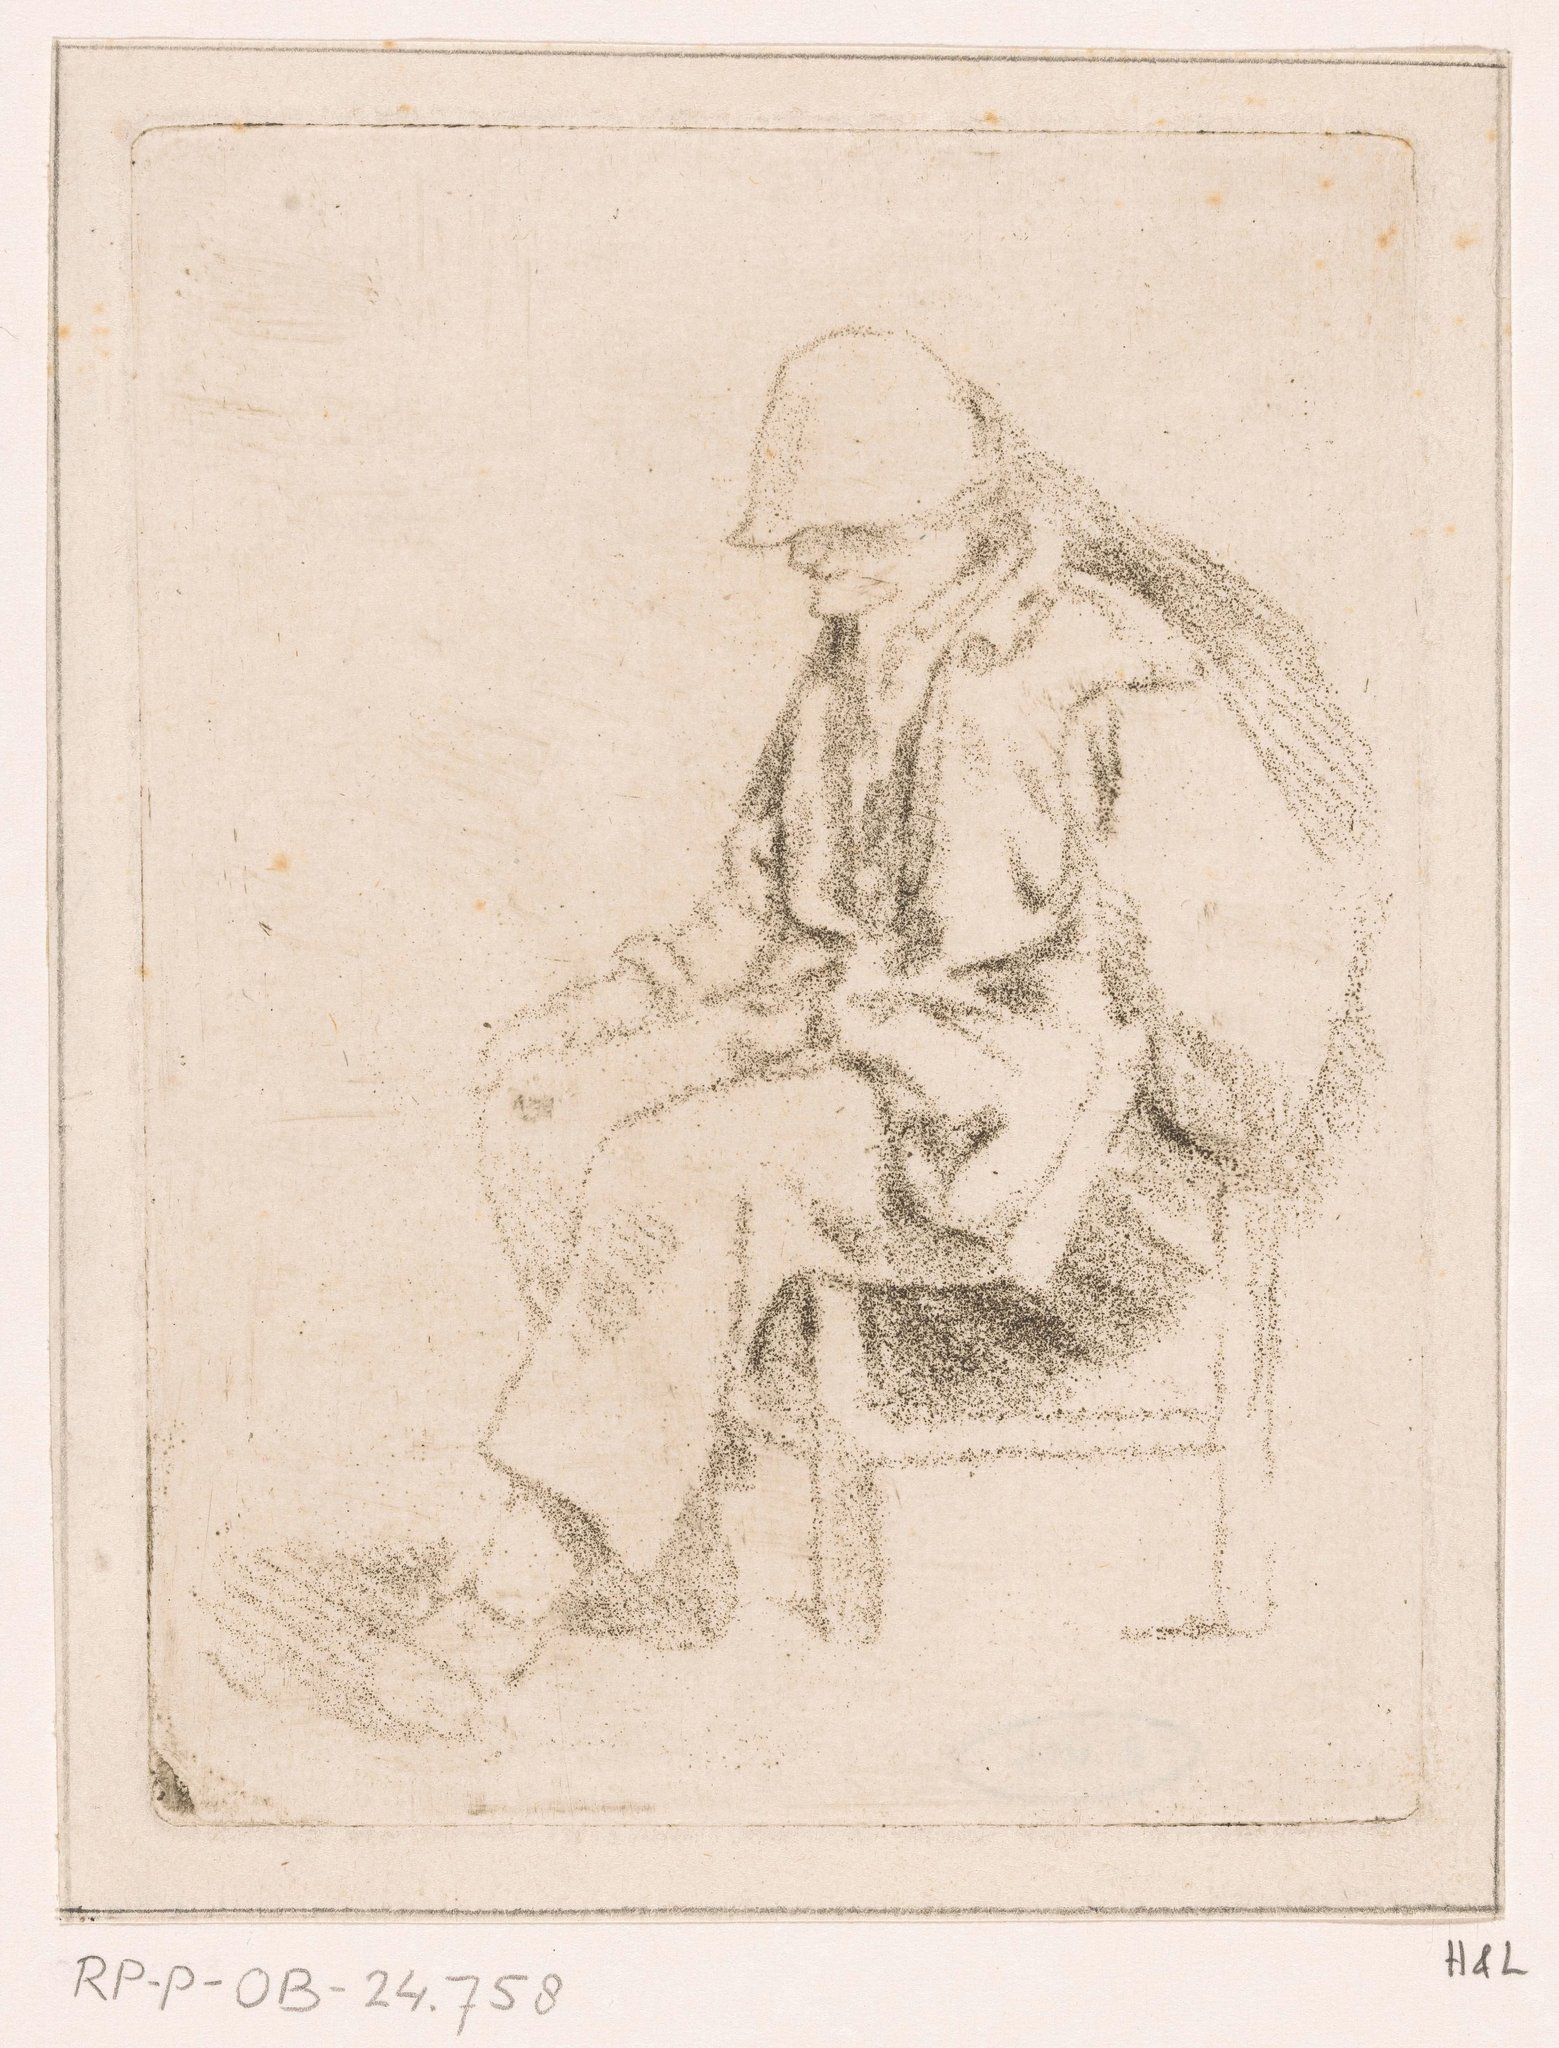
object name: print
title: Zittende man met muts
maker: johannes huibert prins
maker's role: draughtsman, painter, print maker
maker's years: 1757-1806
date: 1783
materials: paper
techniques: printmaking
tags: sitting figure, head-gear: cap (+ men's clothes)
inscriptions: collector's mark: Lugt 2228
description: Op een kruk zit een man met muts op en jas aan. Zijn hand rust op zijn knie, zijn muts is diep over zijn ogen getrokken.